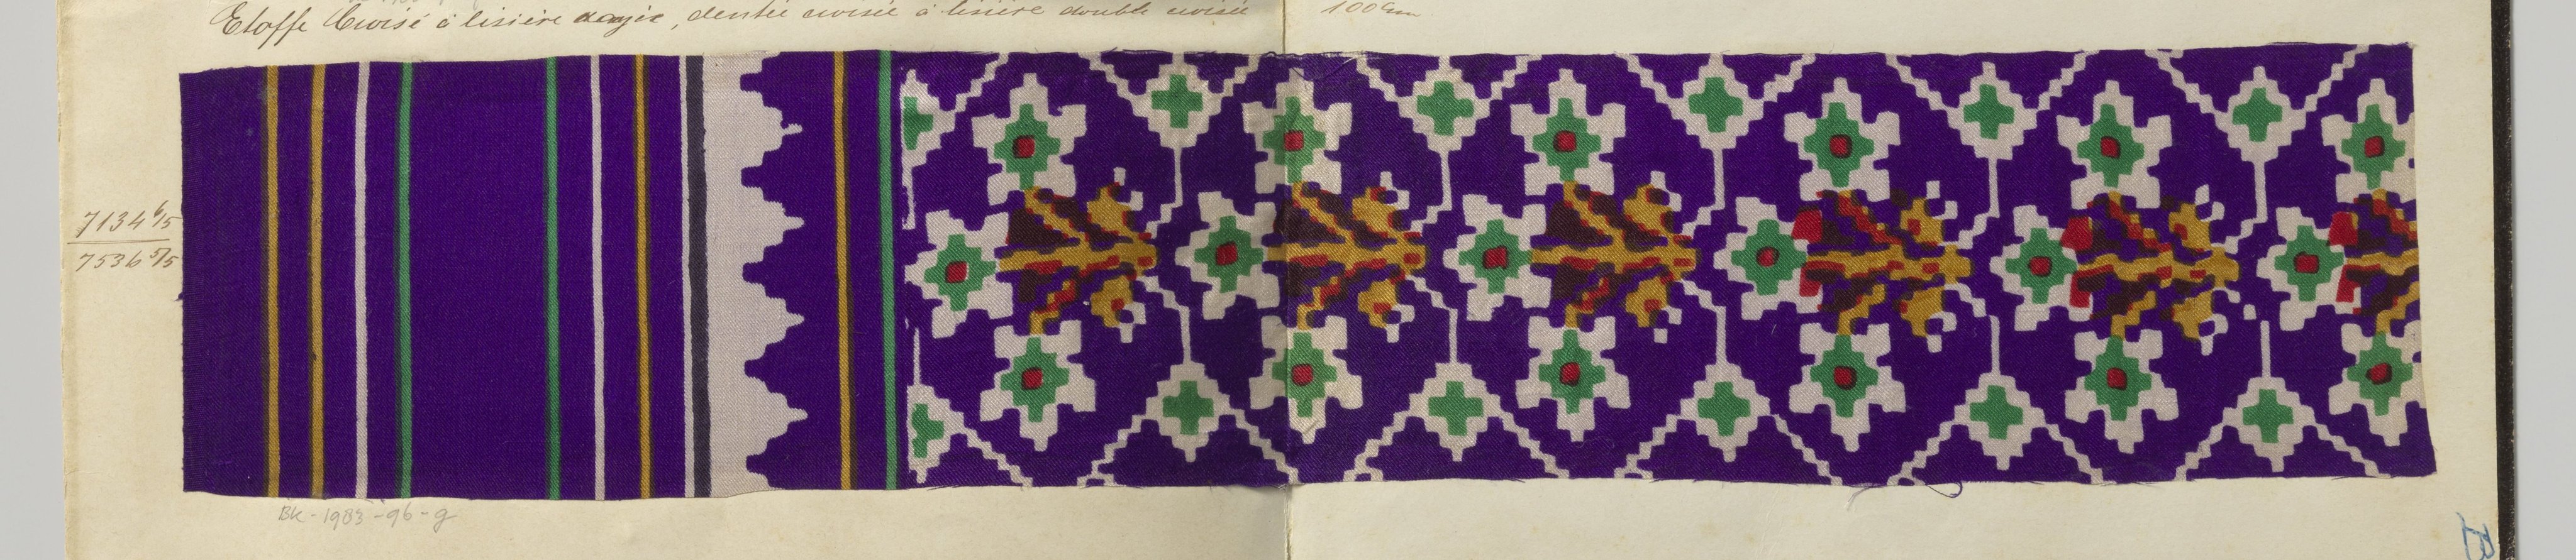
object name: sample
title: Staal zijde in album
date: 1910-1932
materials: silk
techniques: printing block, weave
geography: vienna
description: Staal bedrukte zijde, blauw, groen, rood en geel op naturel, met gestileerde bloemplant binnen paralellepipedum-vormige omlijsting (dessinnr. 7134 6/5 736 5/5)